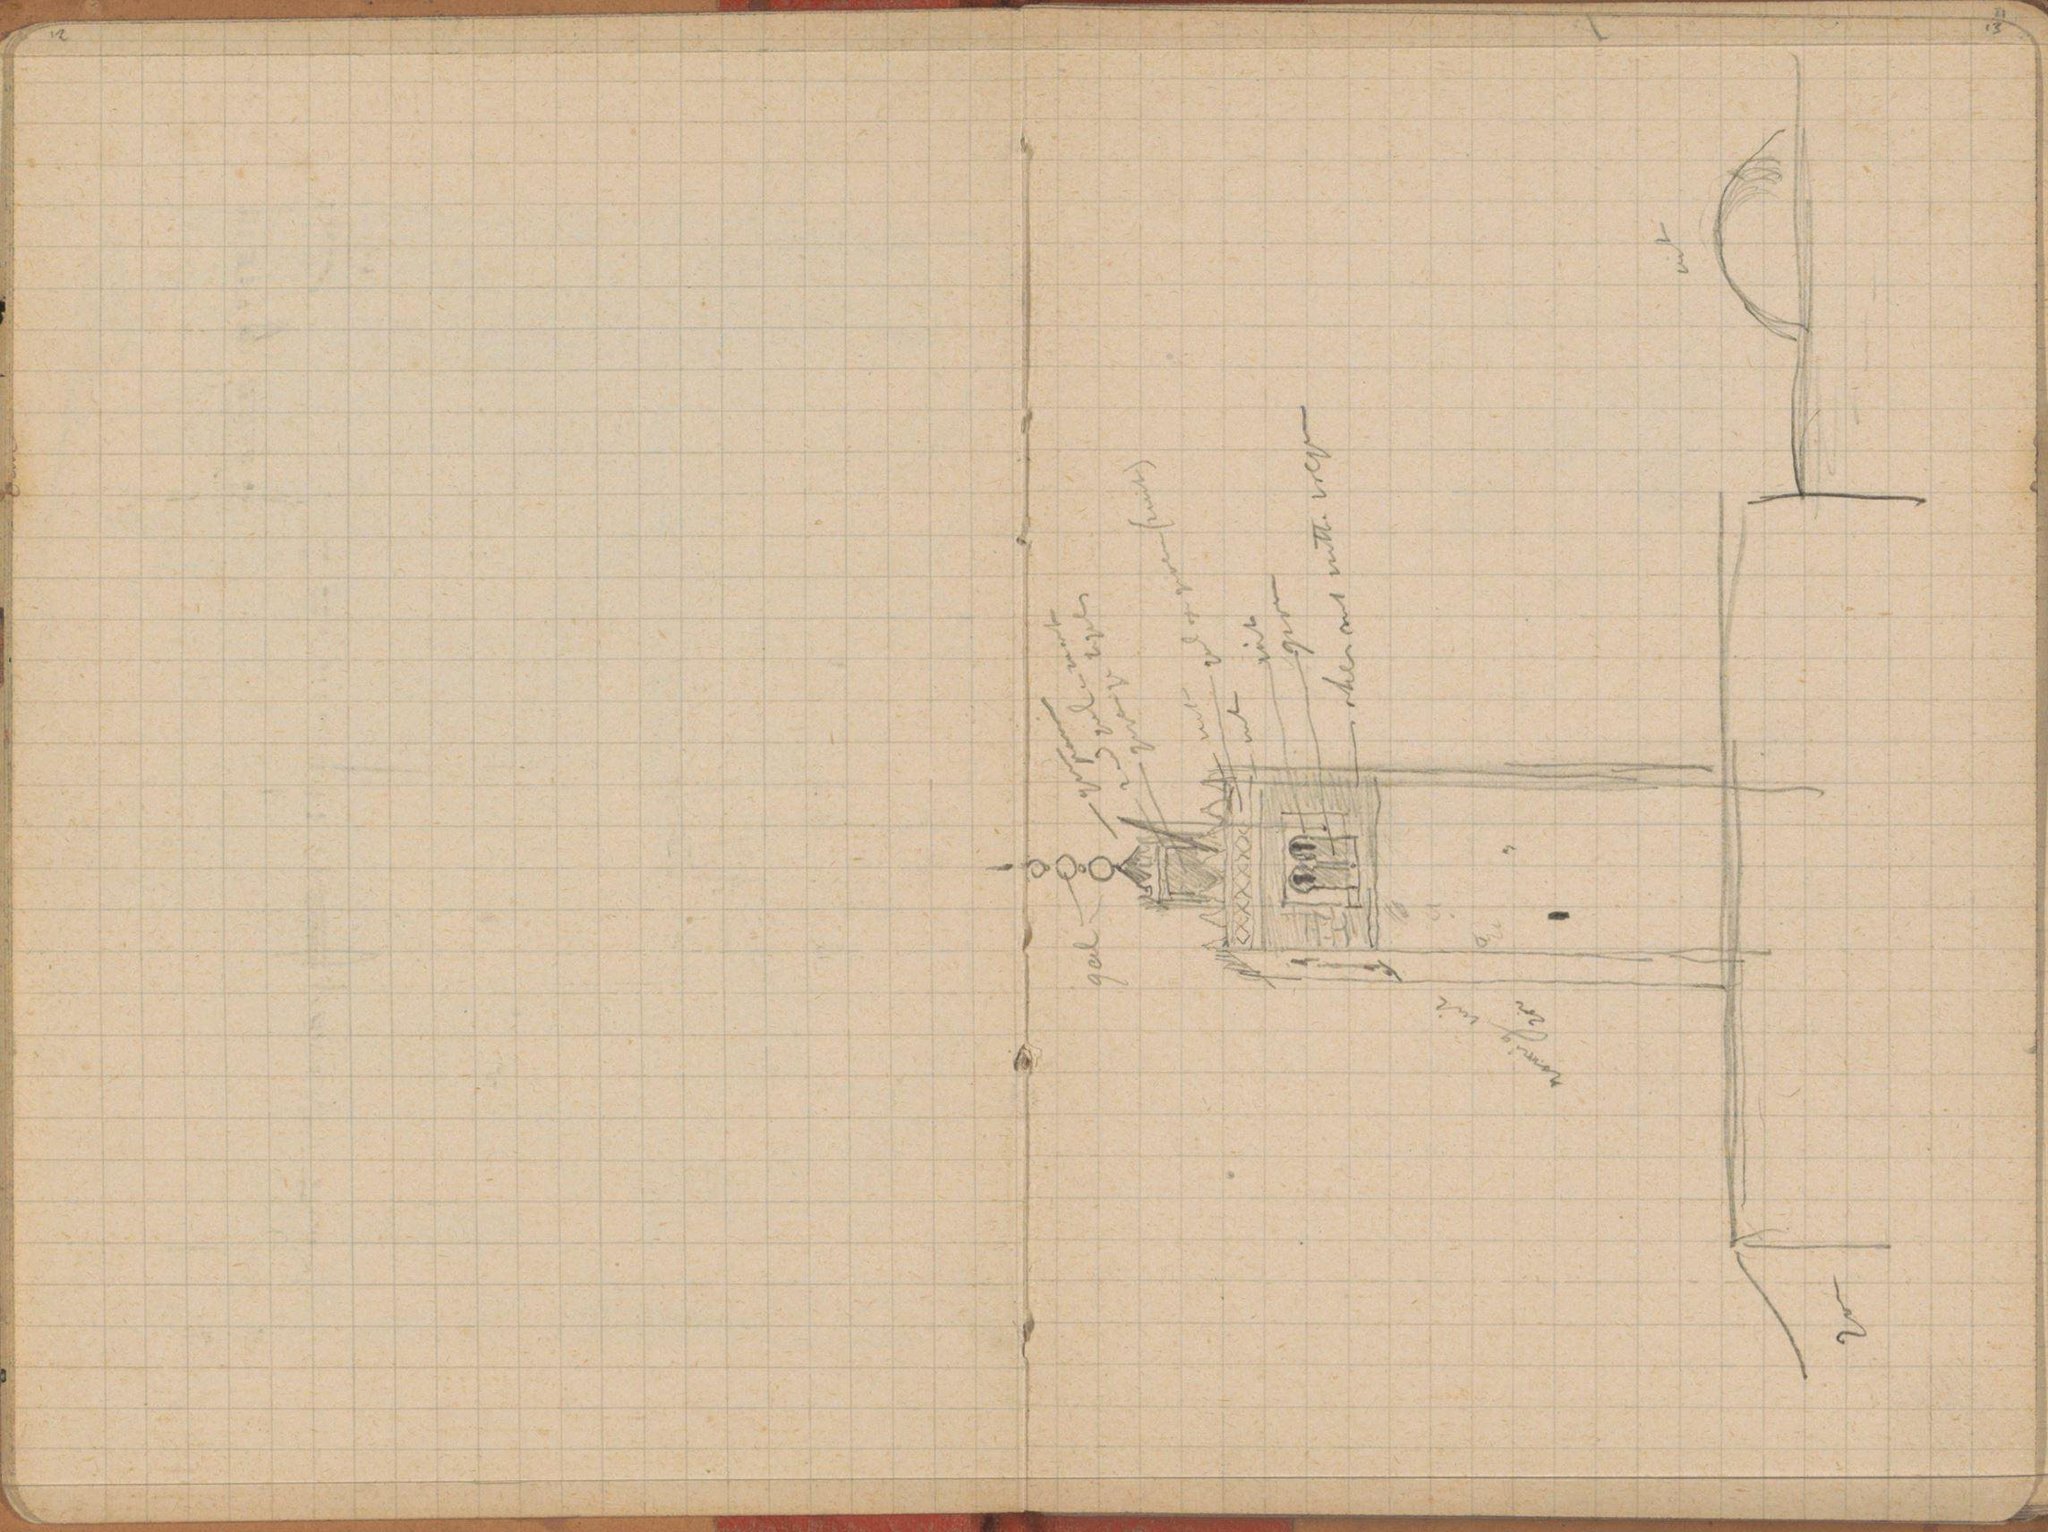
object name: sketchbook leaf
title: Toren van de Al-Zaytuna Moskee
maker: marius bauer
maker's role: draughtsman, print maker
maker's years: 1867-1932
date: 1909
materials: pencil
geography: tunis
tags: temple, shrine ~ islam, mohammedanism, tower (of house or building)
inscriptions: kleurnotitie, handgeschreven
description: Pagina 13 uit een schetsboek met 67 bladen.